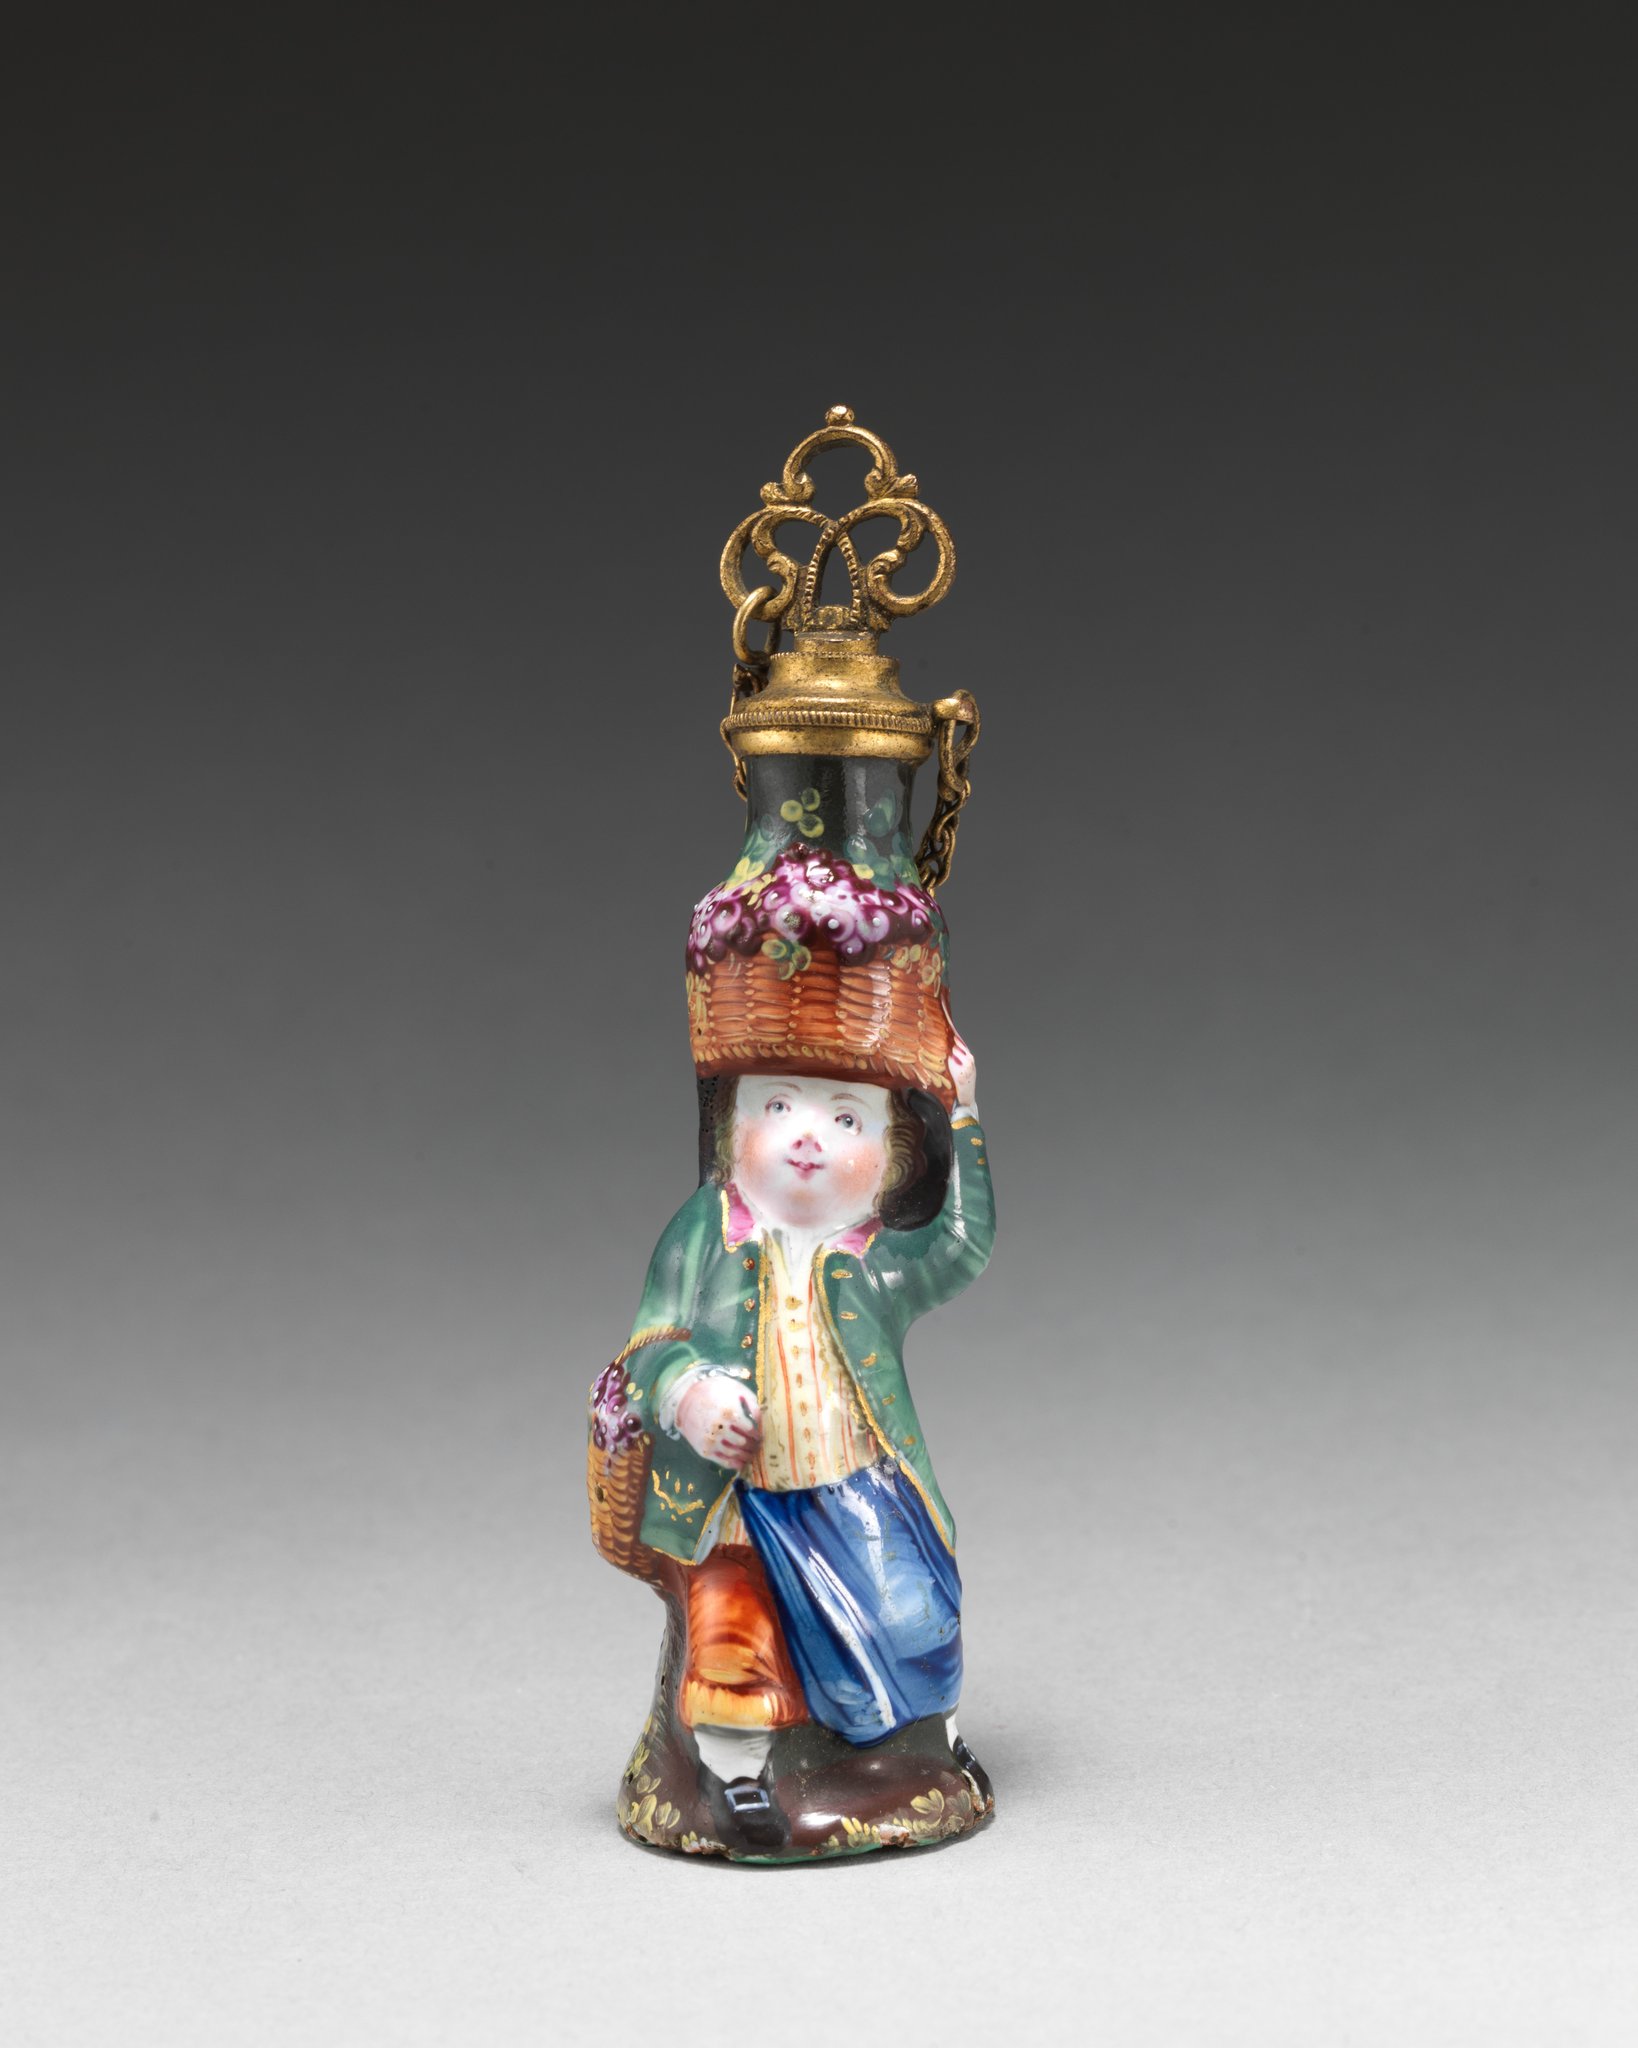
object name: scent bottle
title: Gardener with grapes scent bottle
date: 1760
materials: copper, enamel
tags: boys